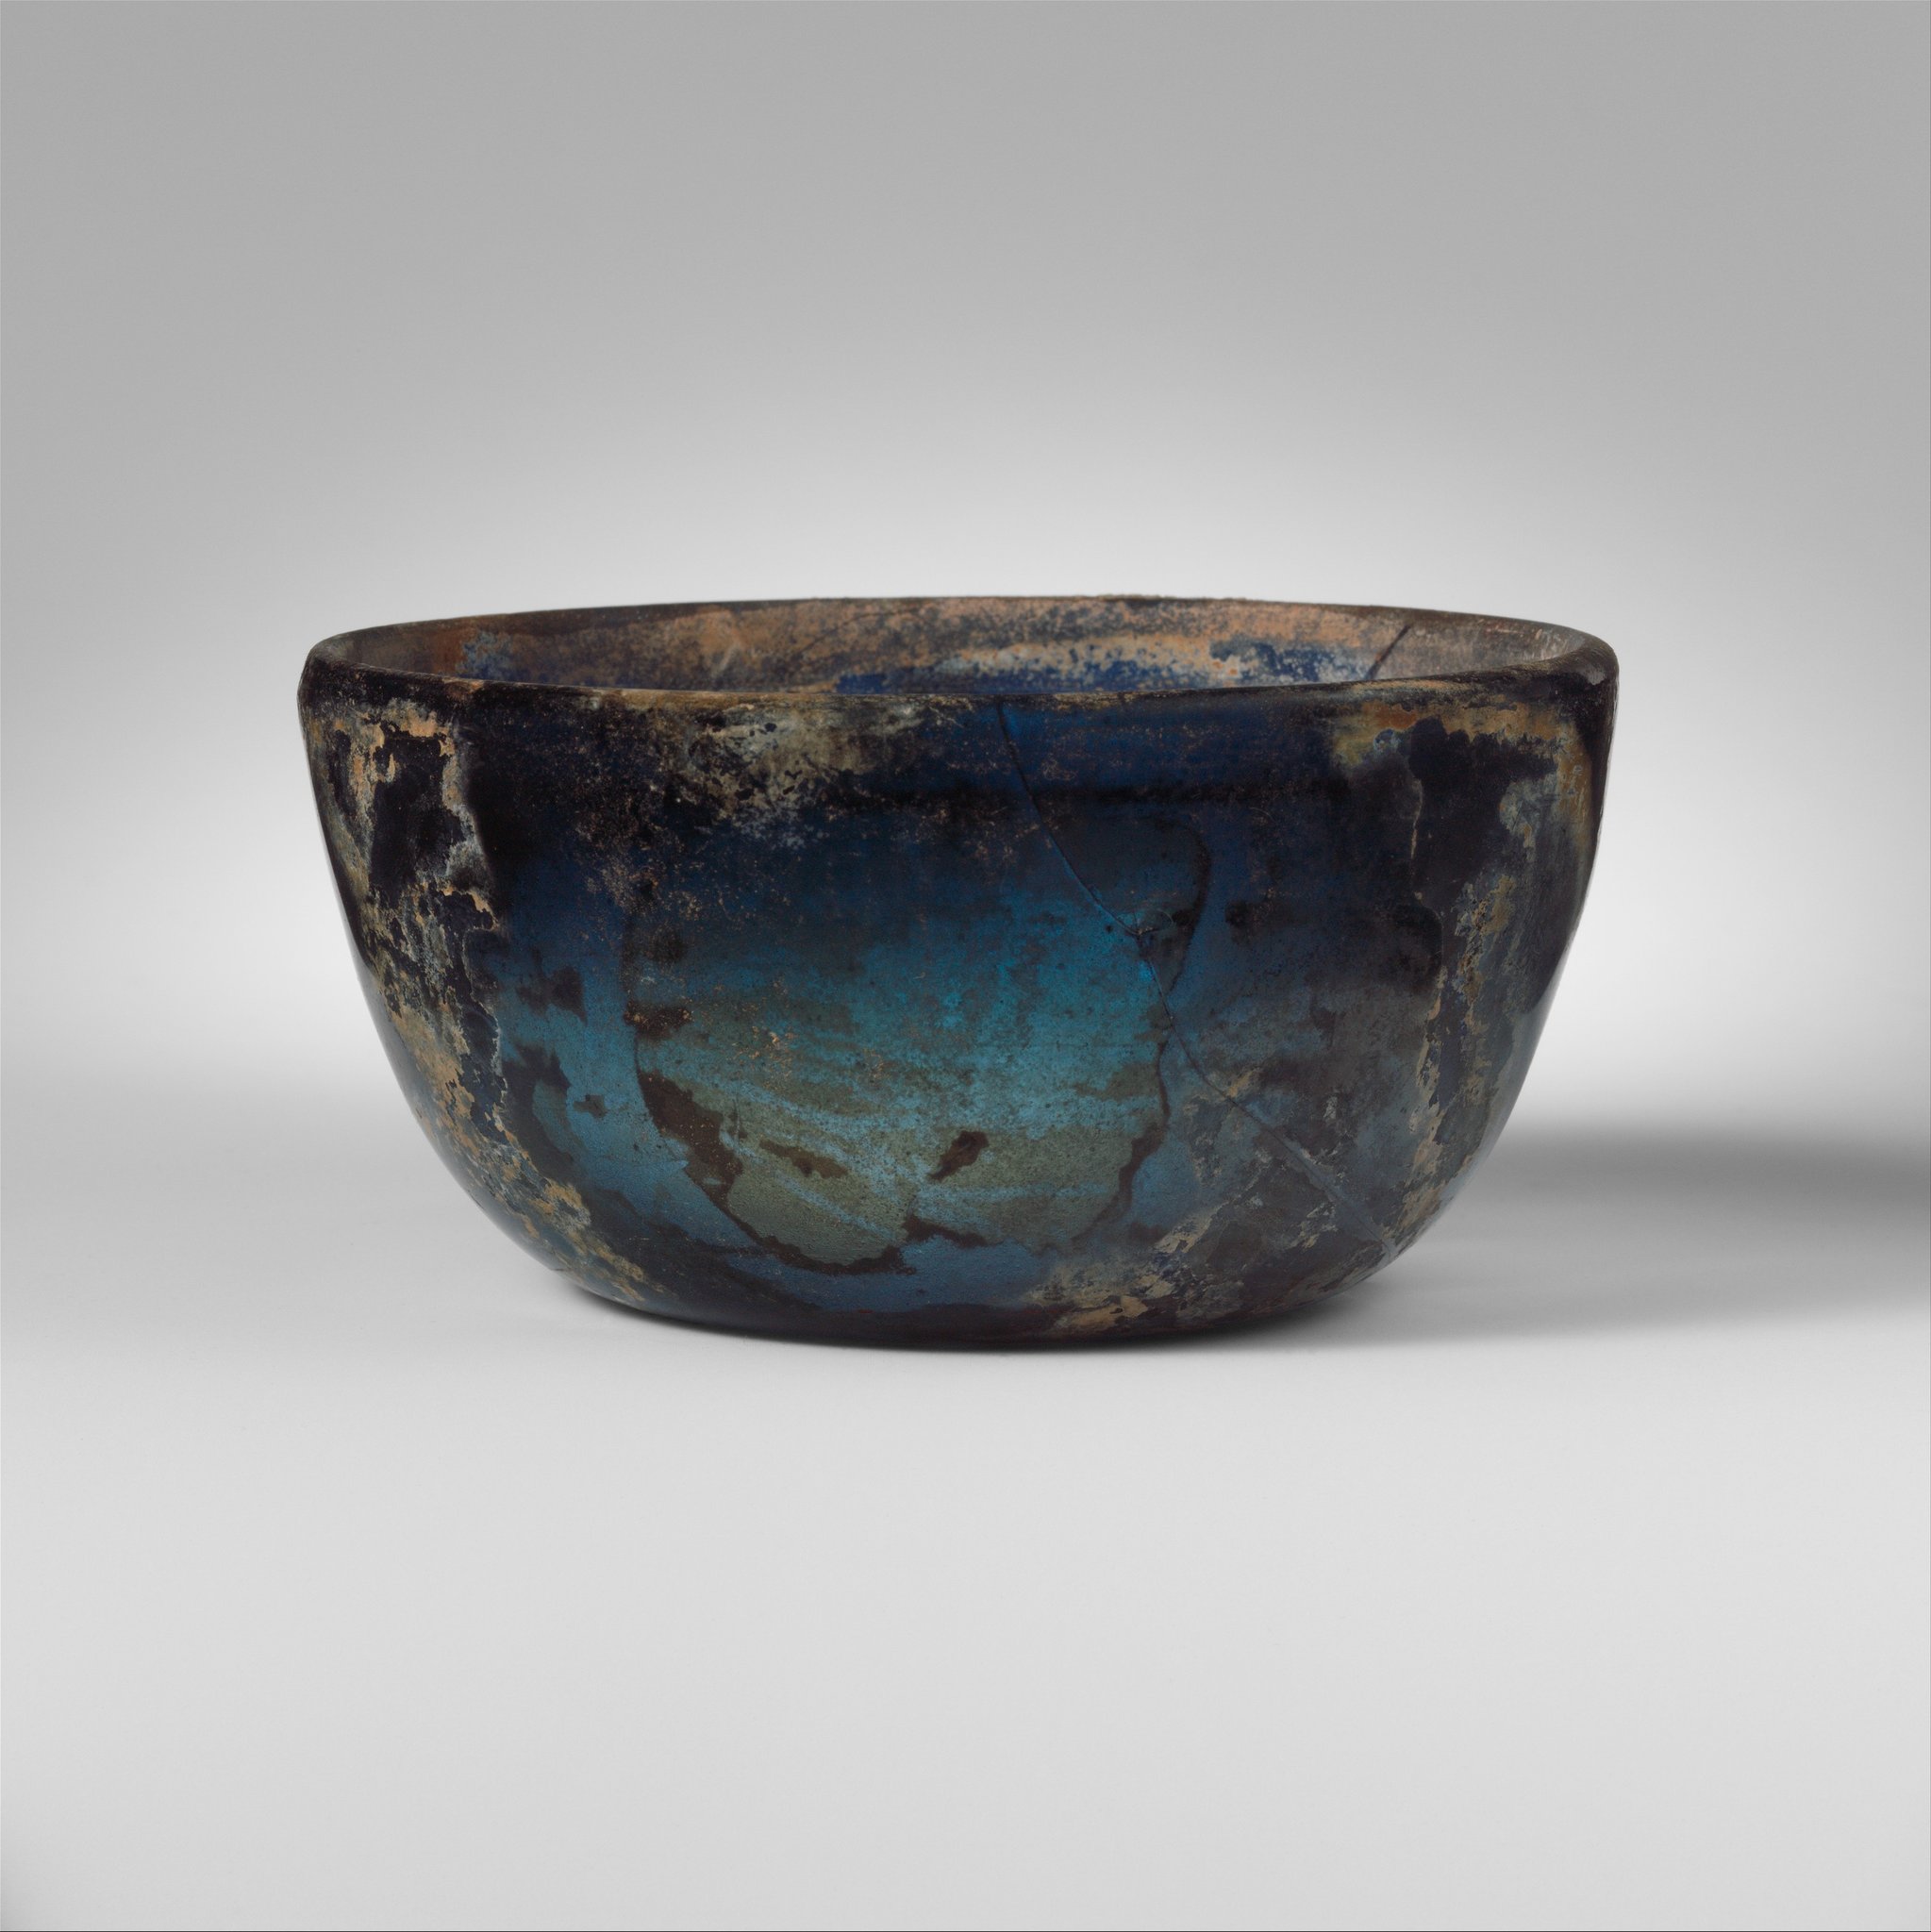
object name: bowl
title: Glass bowl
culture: roman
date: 34 BCE-33 CE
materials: glass